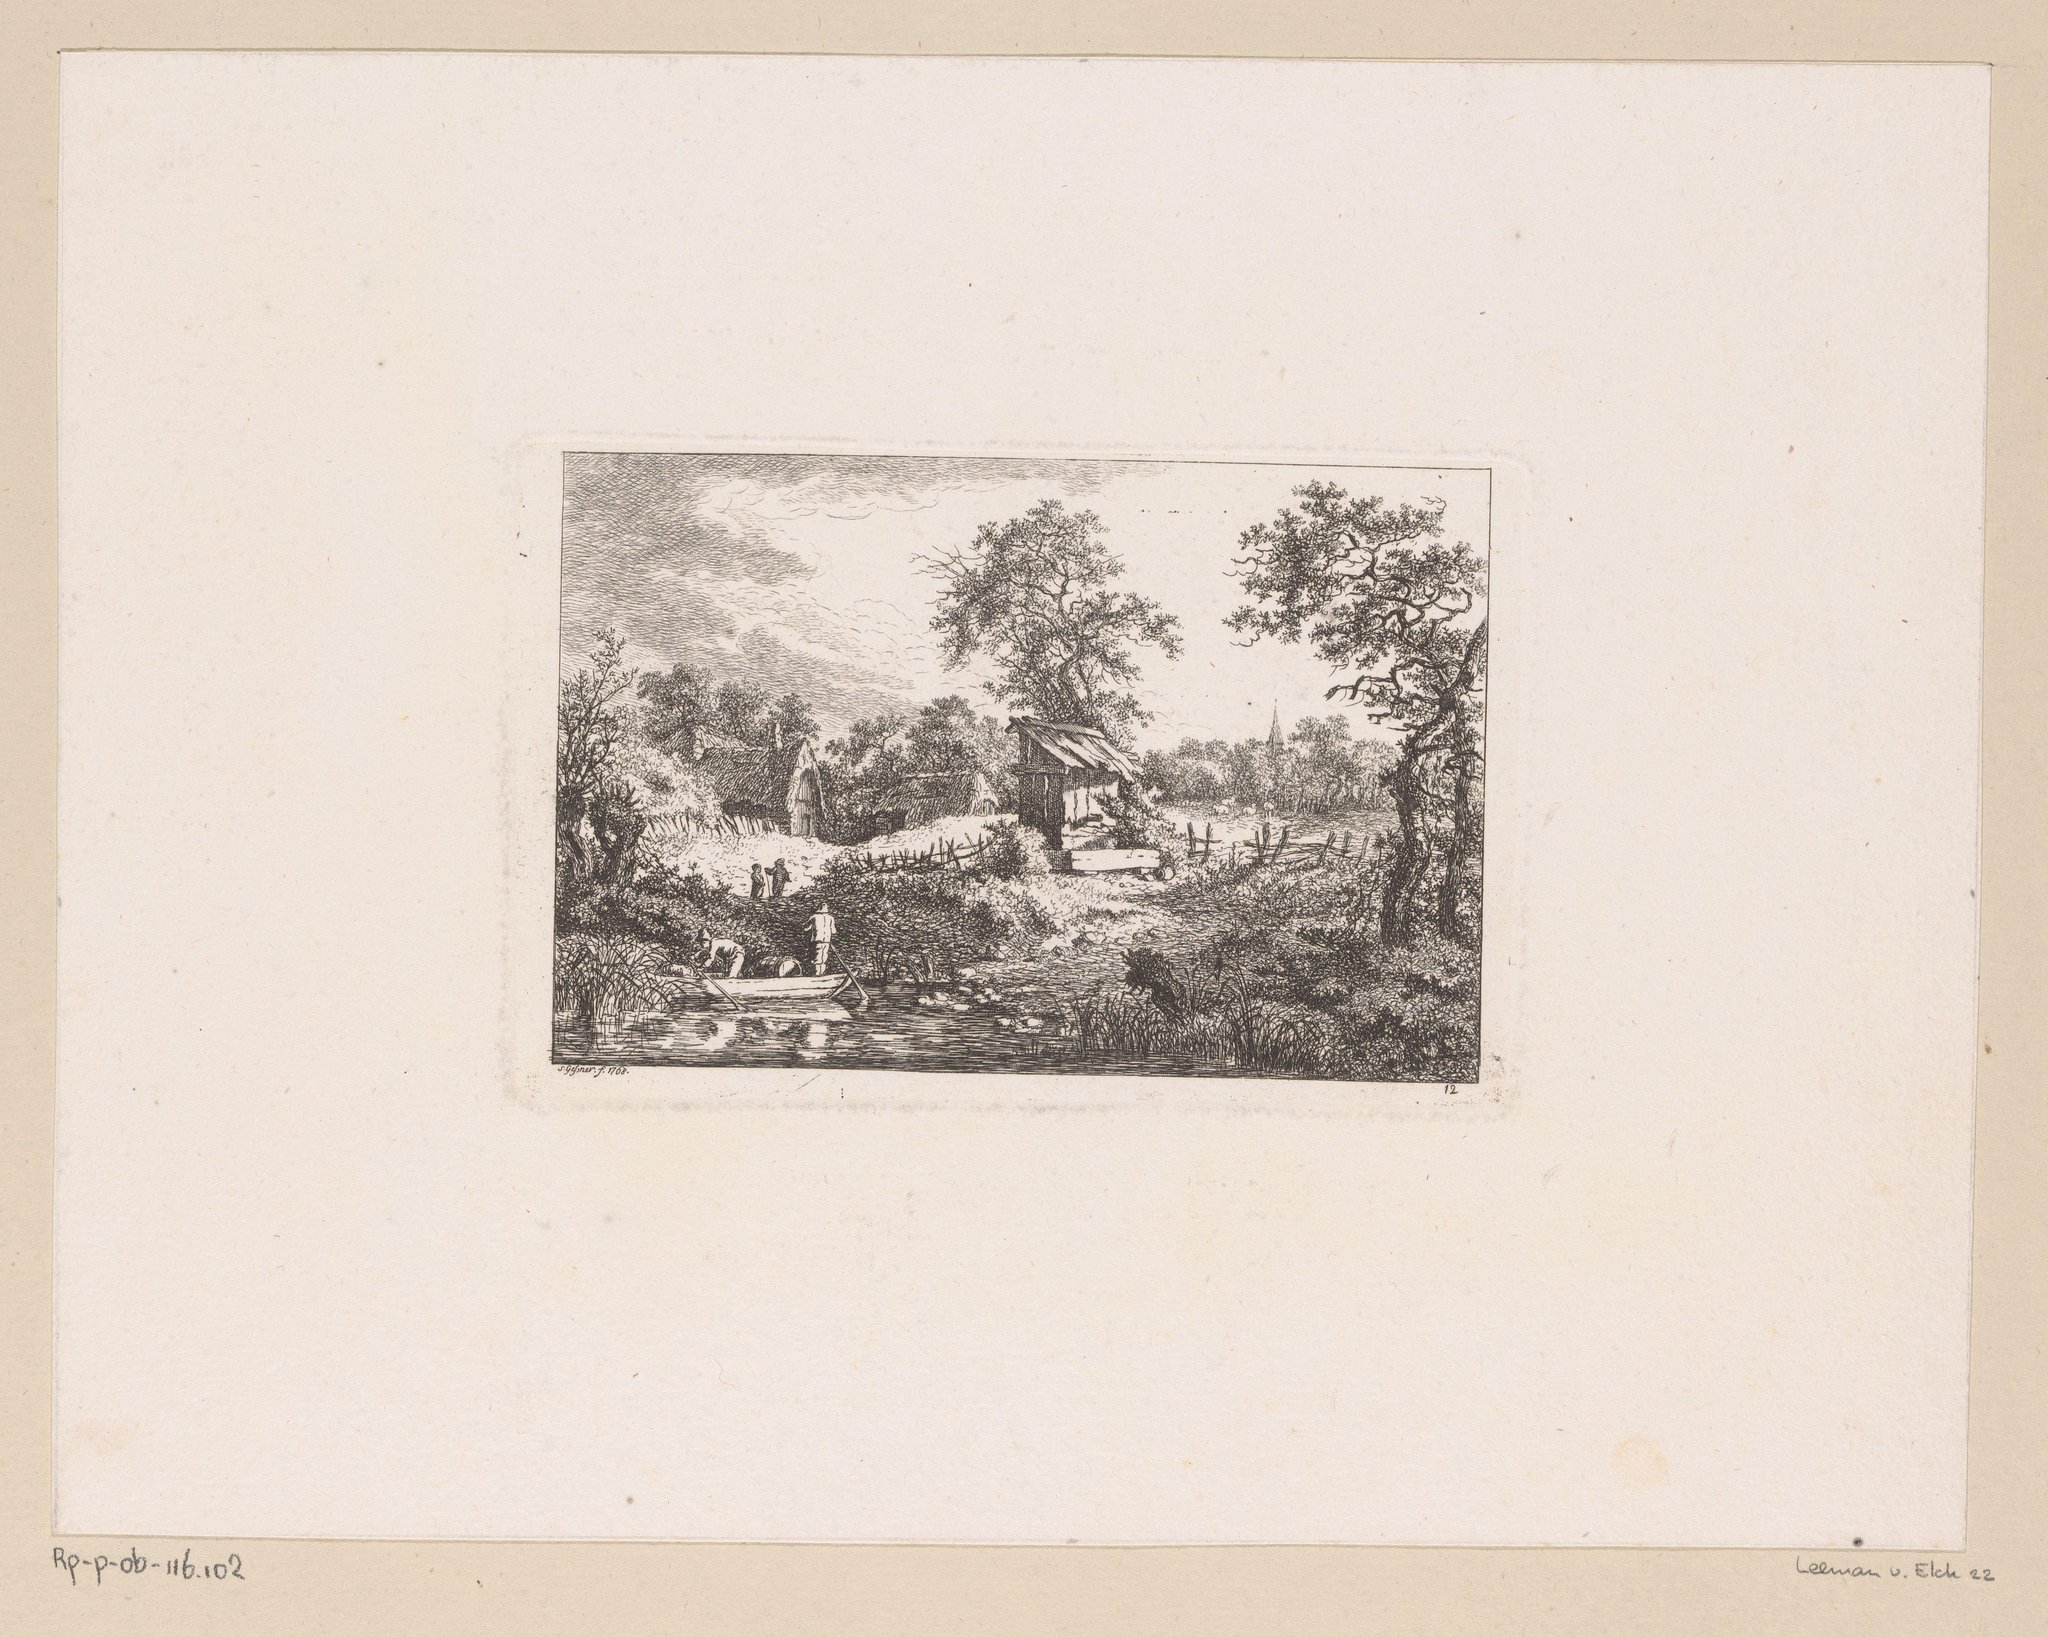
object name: print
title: Arcadische landschappen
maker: salomon gessner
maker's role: painter, print maker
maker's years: 1730-1788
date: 1768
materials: paper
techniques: etching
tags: village - ii - ideal landscapes, rowing-boat, canoe, etc.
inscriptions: collector's mark: Lugt 240